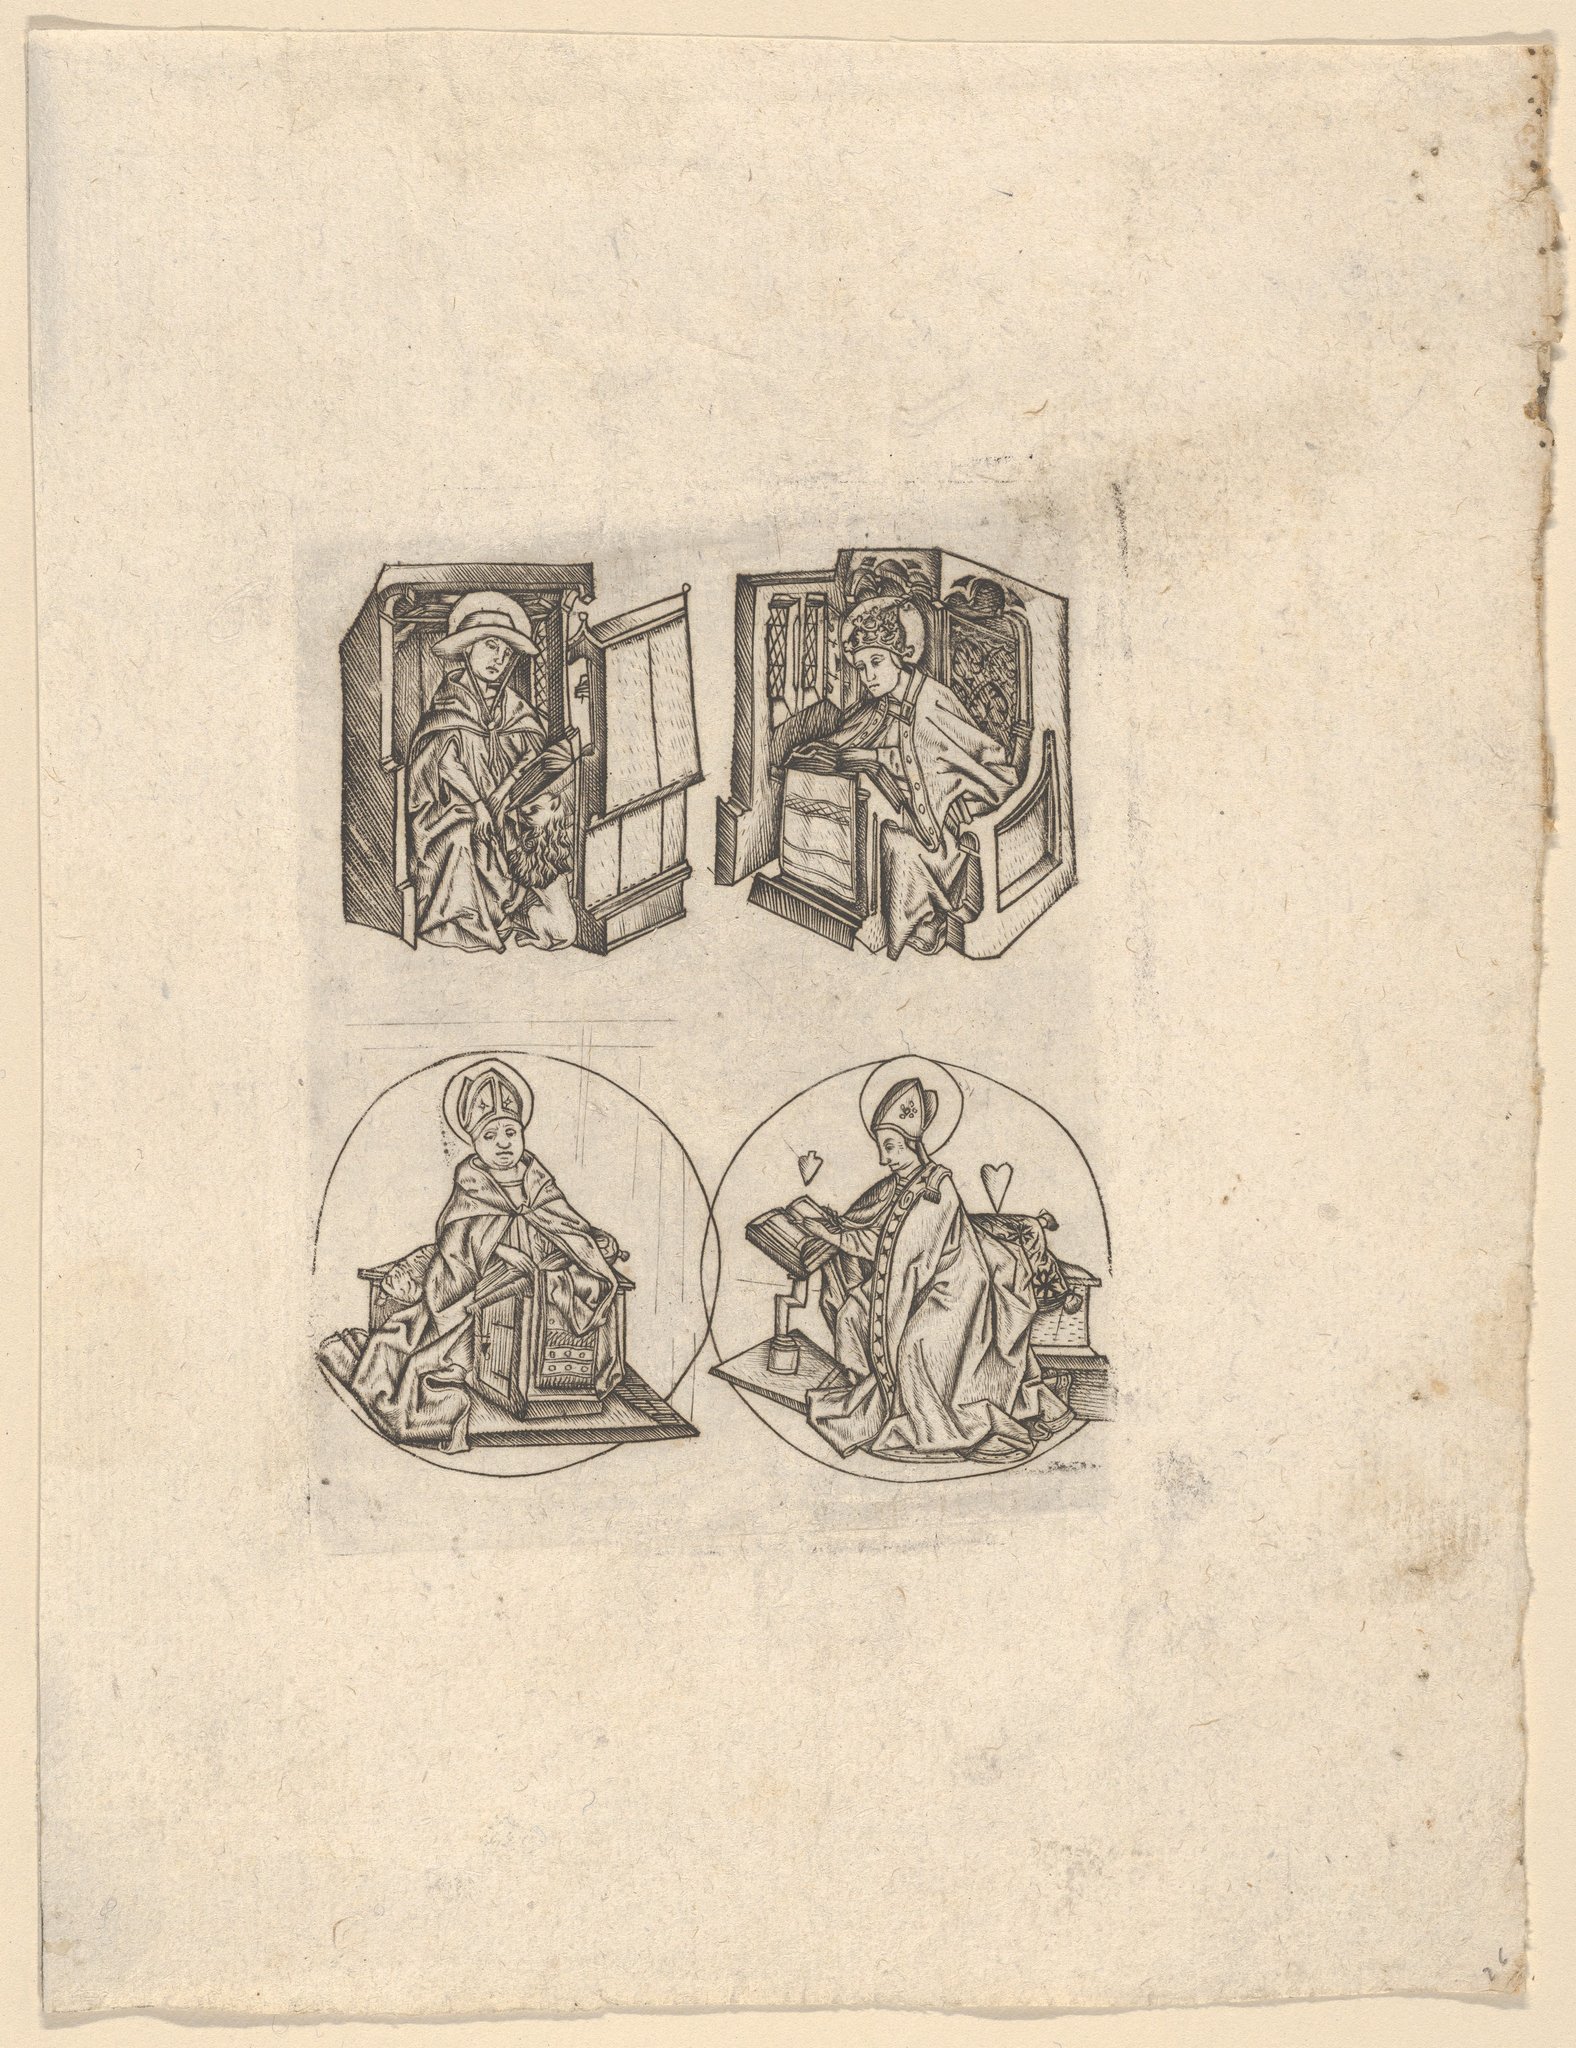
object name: print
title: The Four Fathers of the Church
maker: israhel van meckenem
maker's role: artist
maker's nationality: german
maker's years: 1435-1503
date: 1435-1503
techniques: engraving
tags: men